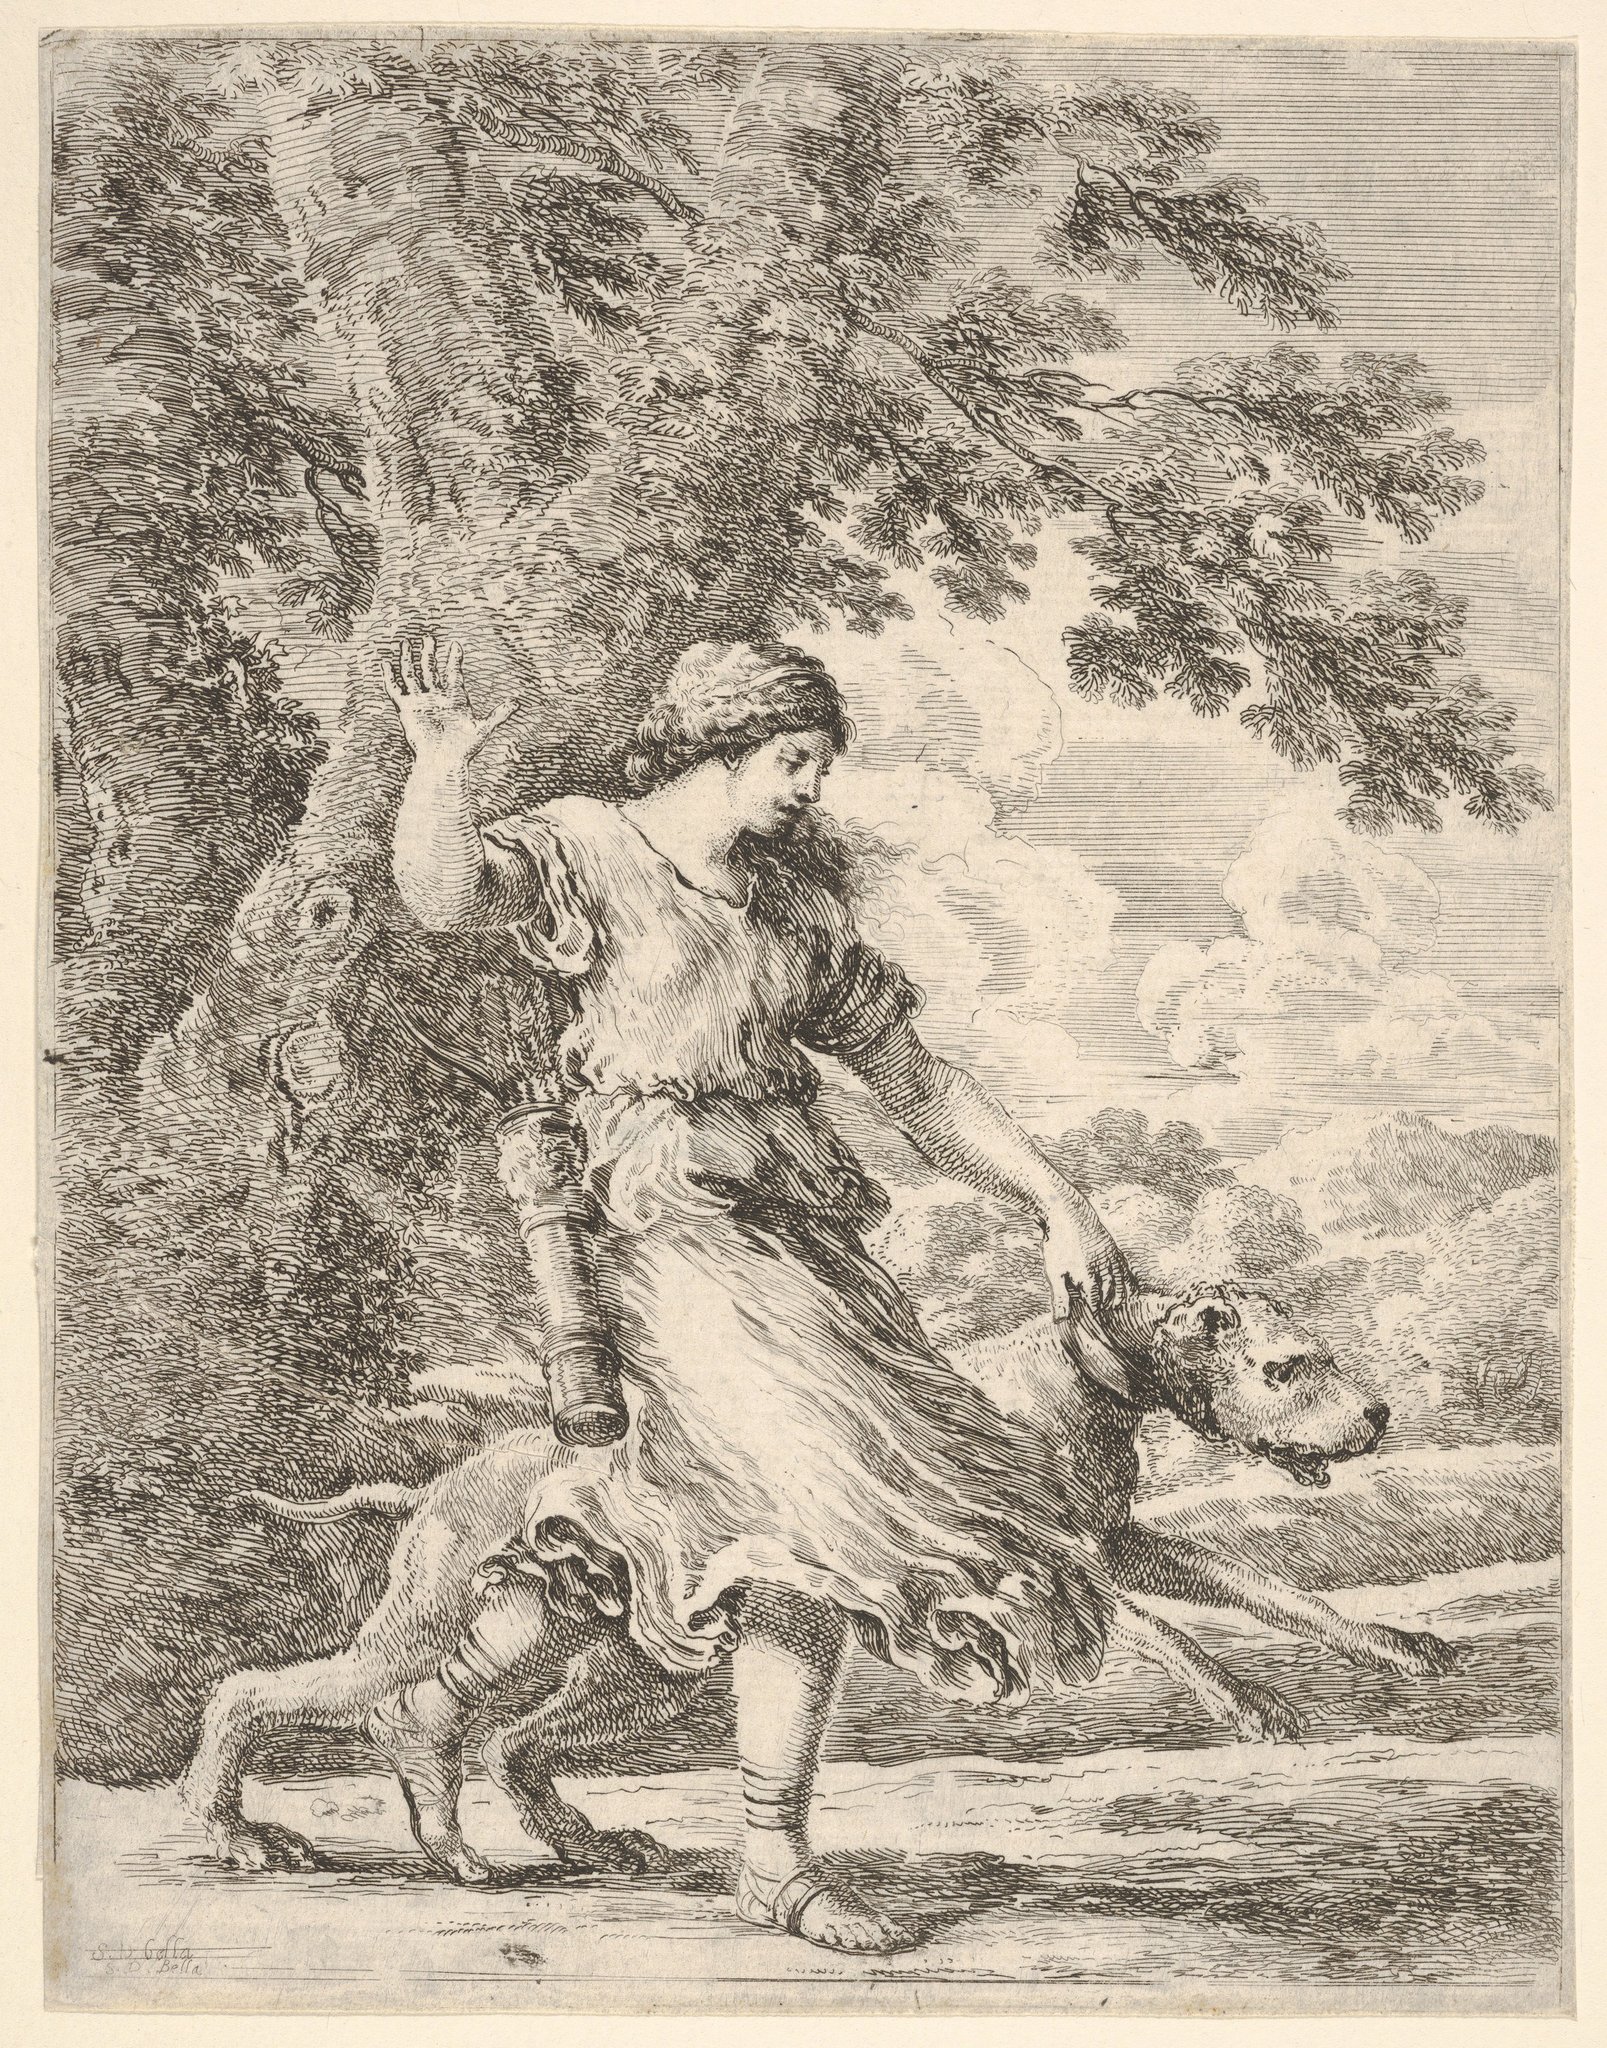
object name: print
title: A nymph holding a large dog by the collar (La belle chasseresse)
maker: stefano della bella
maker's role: artist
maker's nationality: italian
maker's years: 1610-1664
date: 1654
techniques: etching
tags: nymphs,dogs